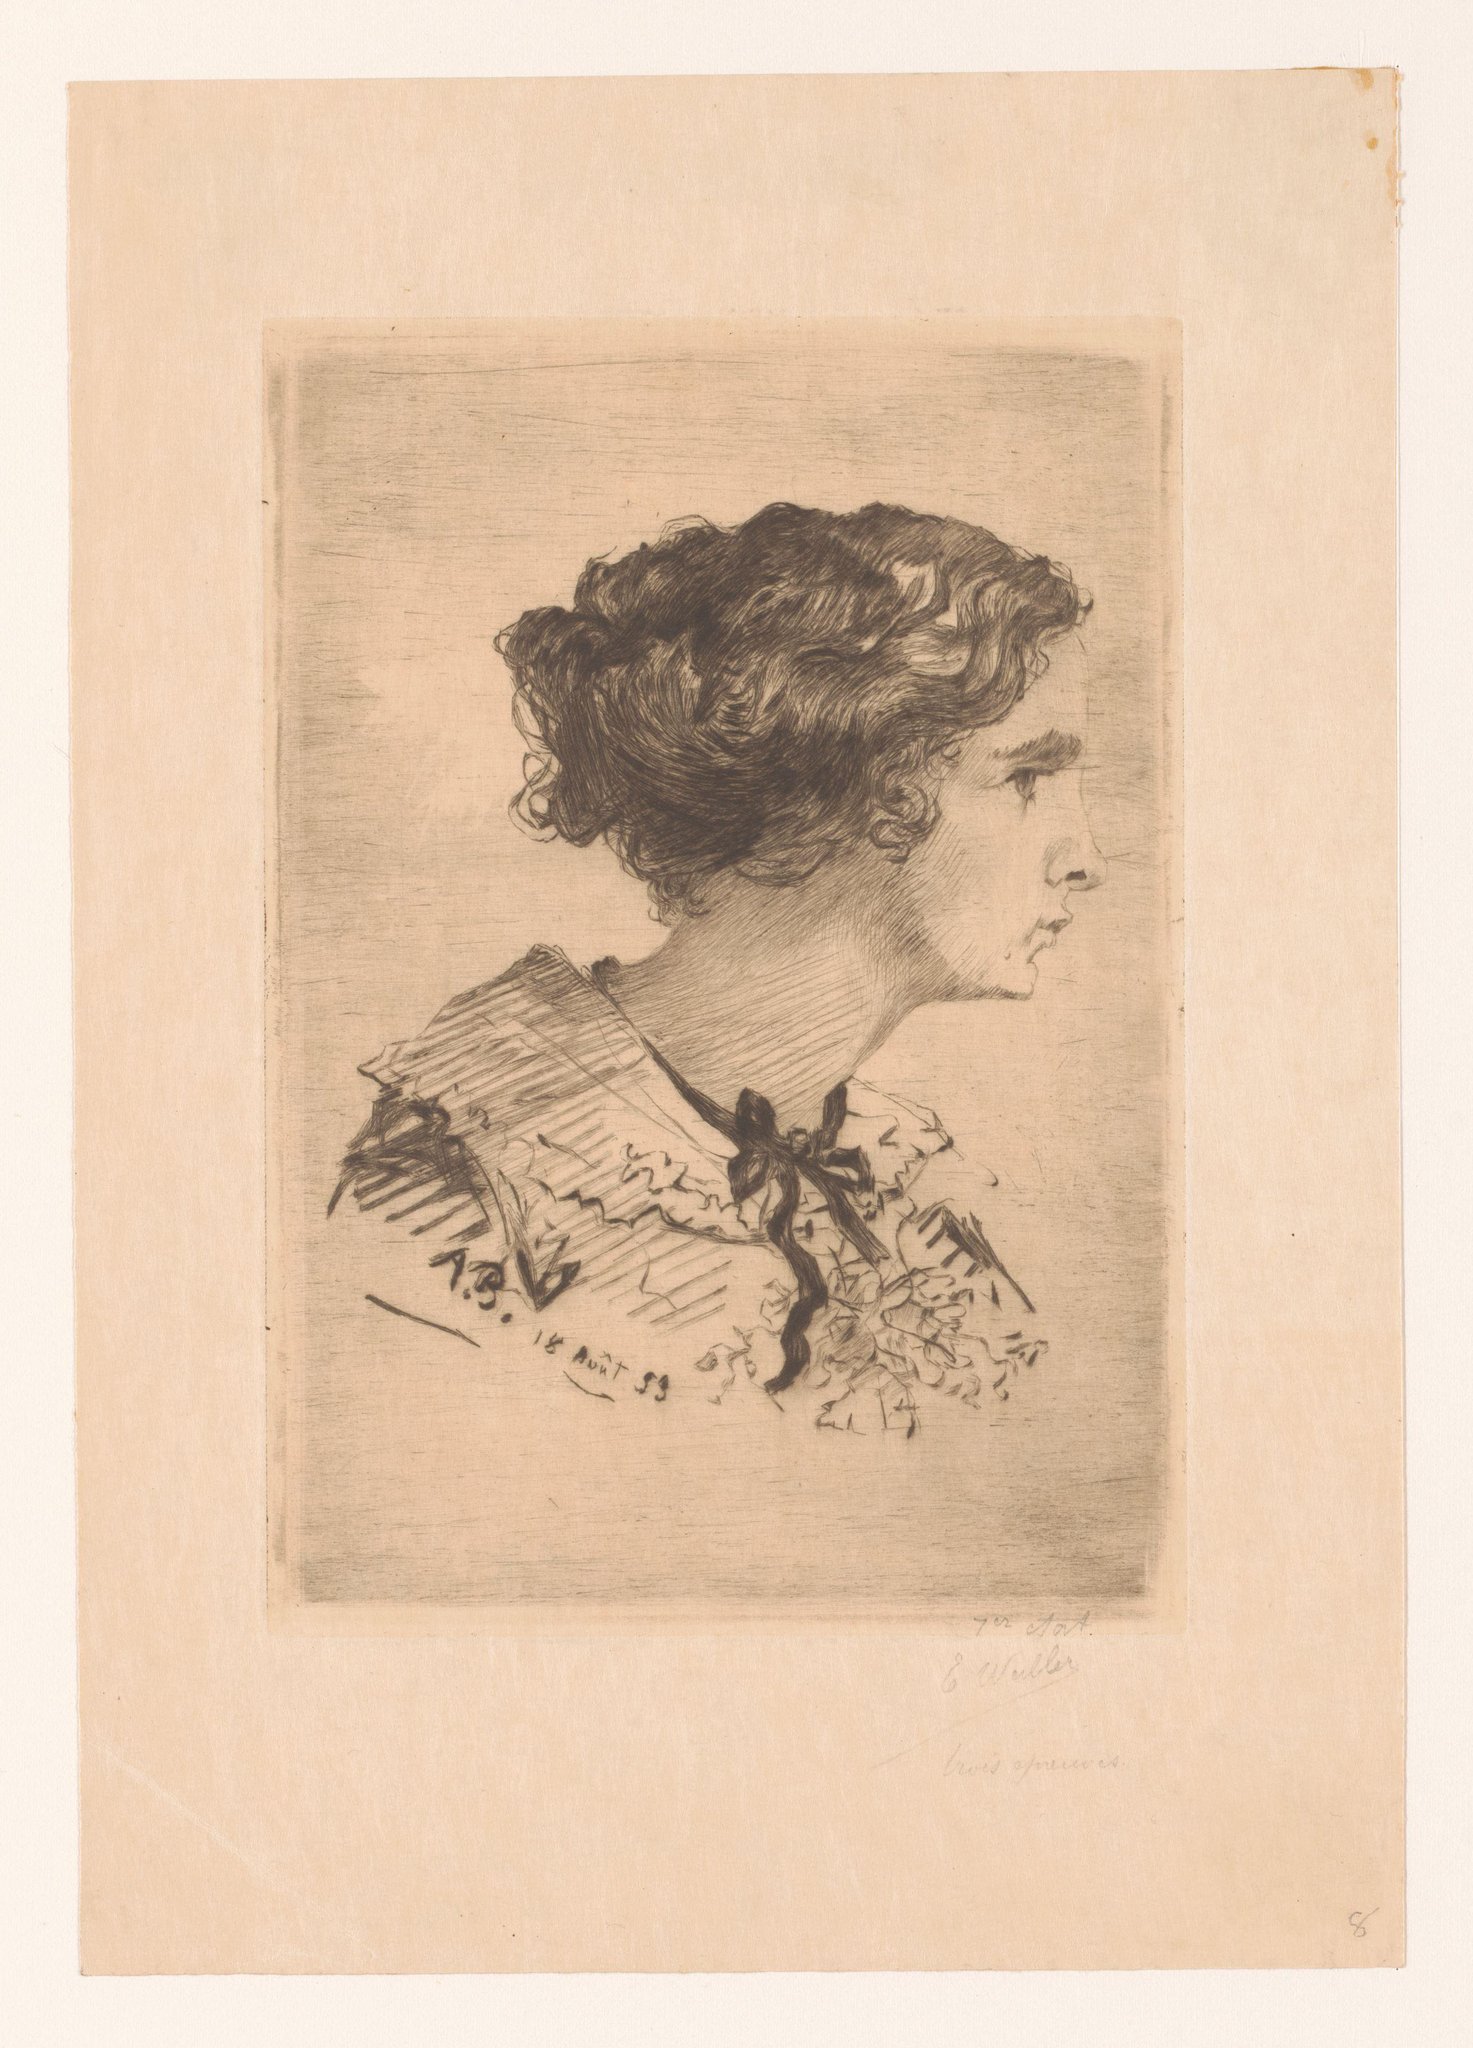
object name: print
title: Portret van een onbekende vrouw, mogelijk barones van Beaulieu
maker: elisa weiler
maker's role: print maker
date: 1875-1913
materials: paper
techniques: drypoint, etching, intaglio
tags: adult woman, historical persons, border, ribbon, braid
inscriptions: inscription: ‘portrait de mme la [barnne] de Beulieu’, collector's mark: Lugt 2228, inscription: ‘1er etat; trois epreuves’